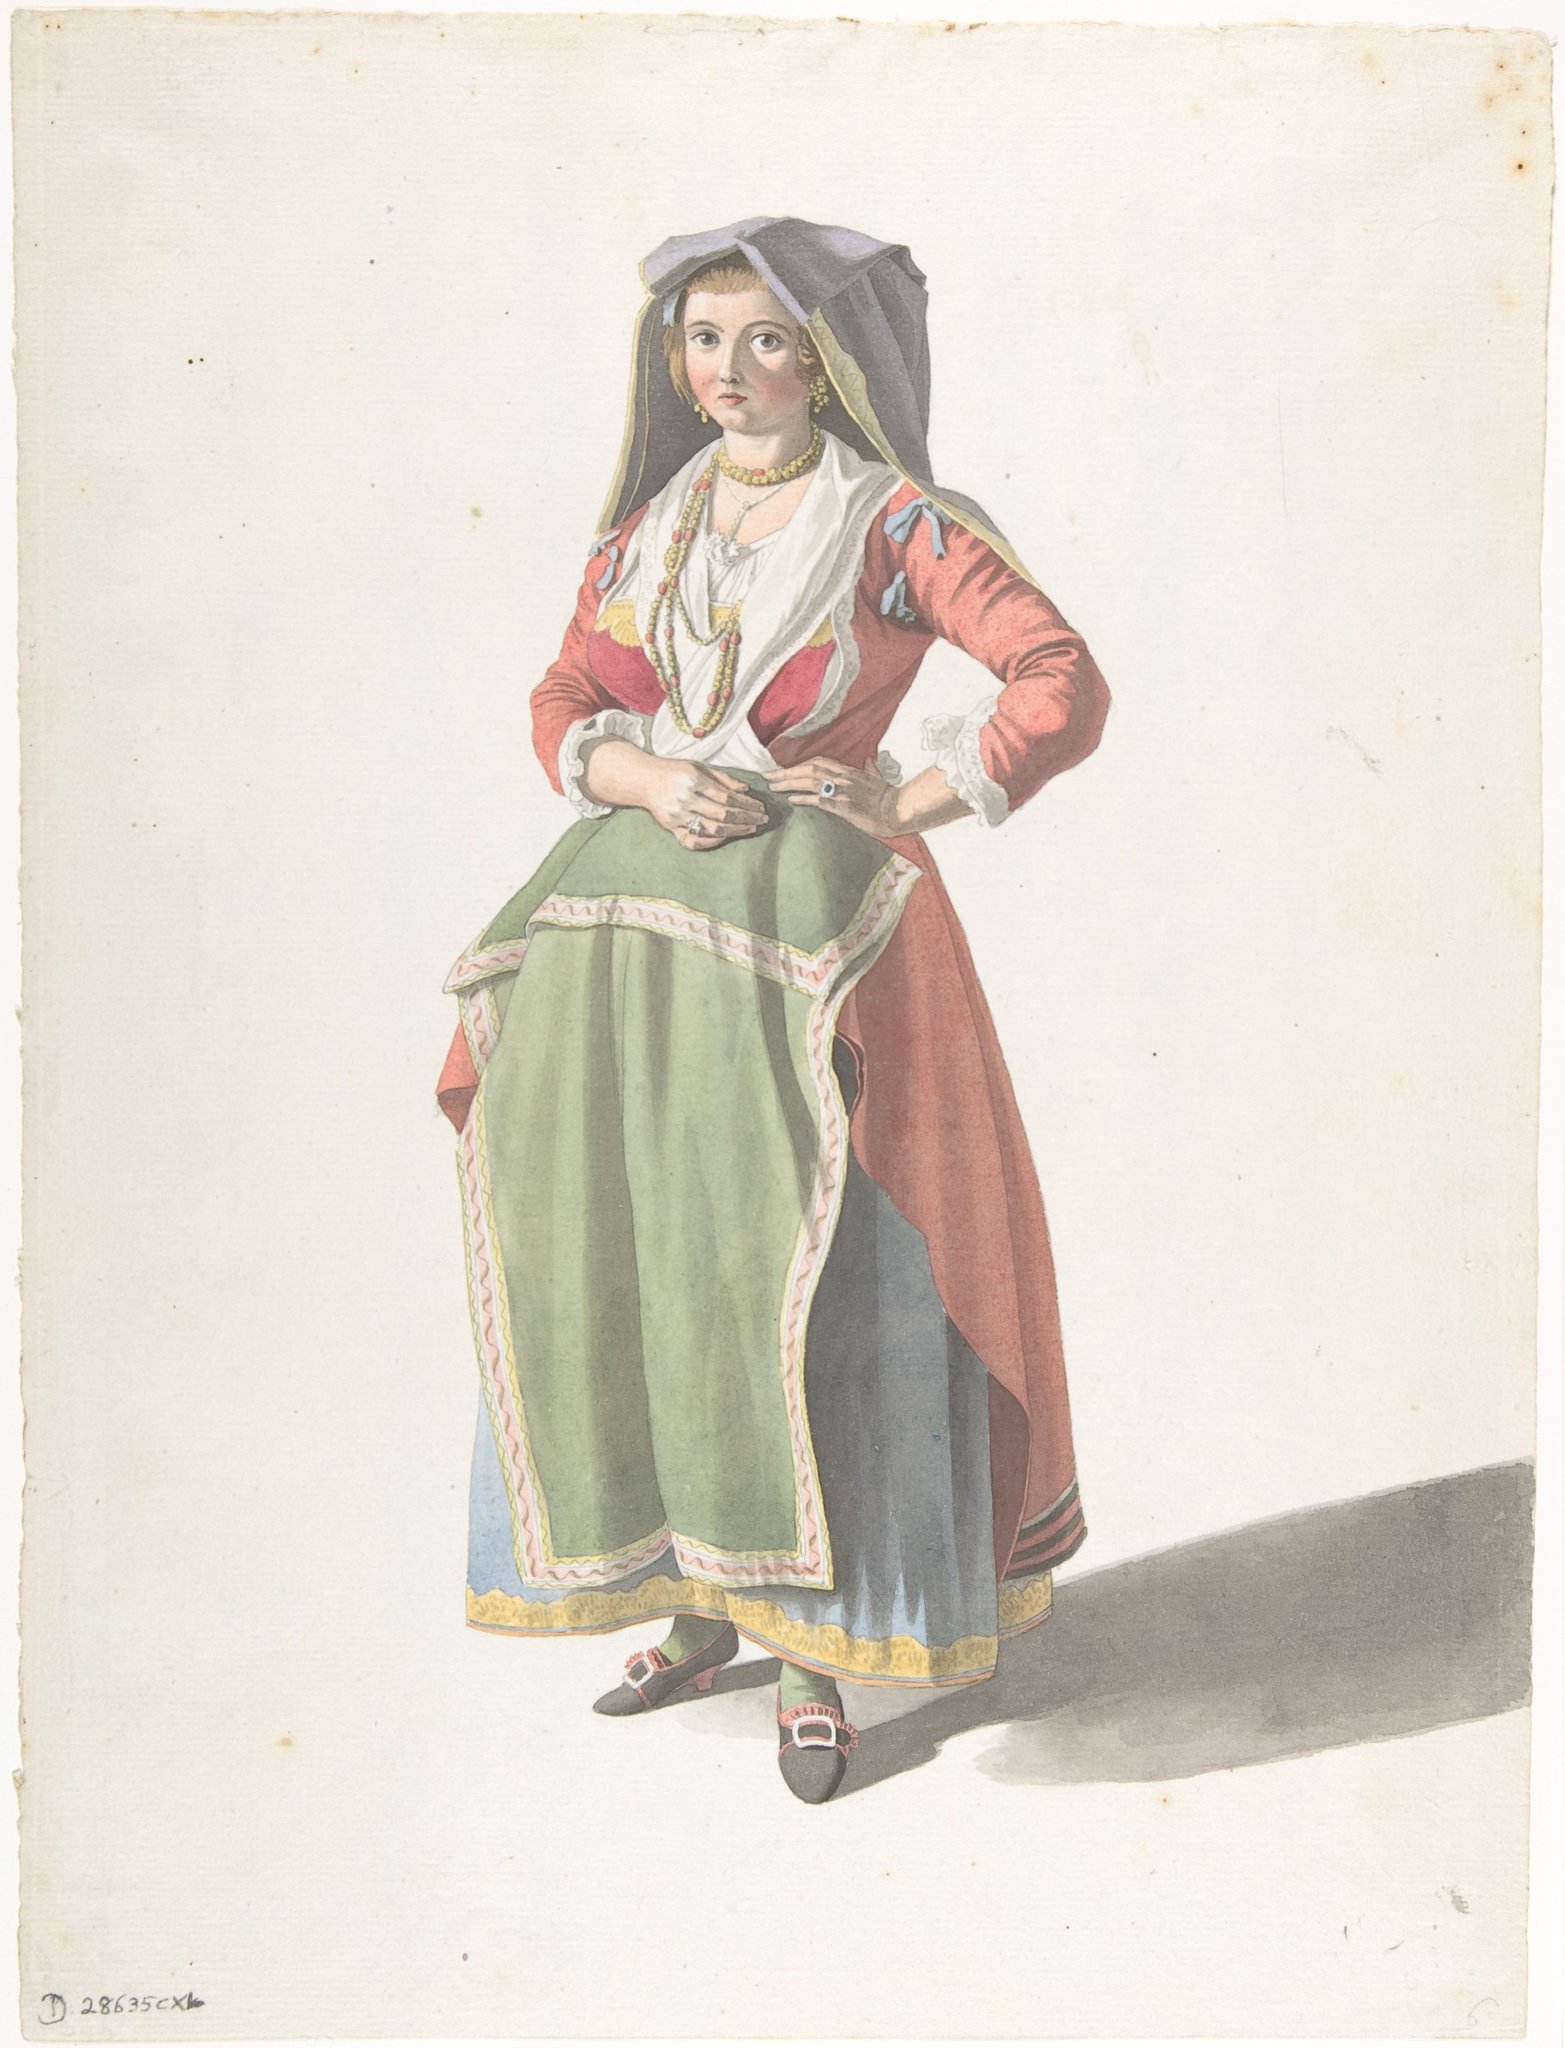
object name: drawing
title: Young Woman Standing in Traditional Neapolitan Dress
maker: giovanni battista ("titta") lusieri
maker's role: artist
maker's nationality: italian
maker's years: 1754-1821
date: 1755-1821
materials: graphite, watercolor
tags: women